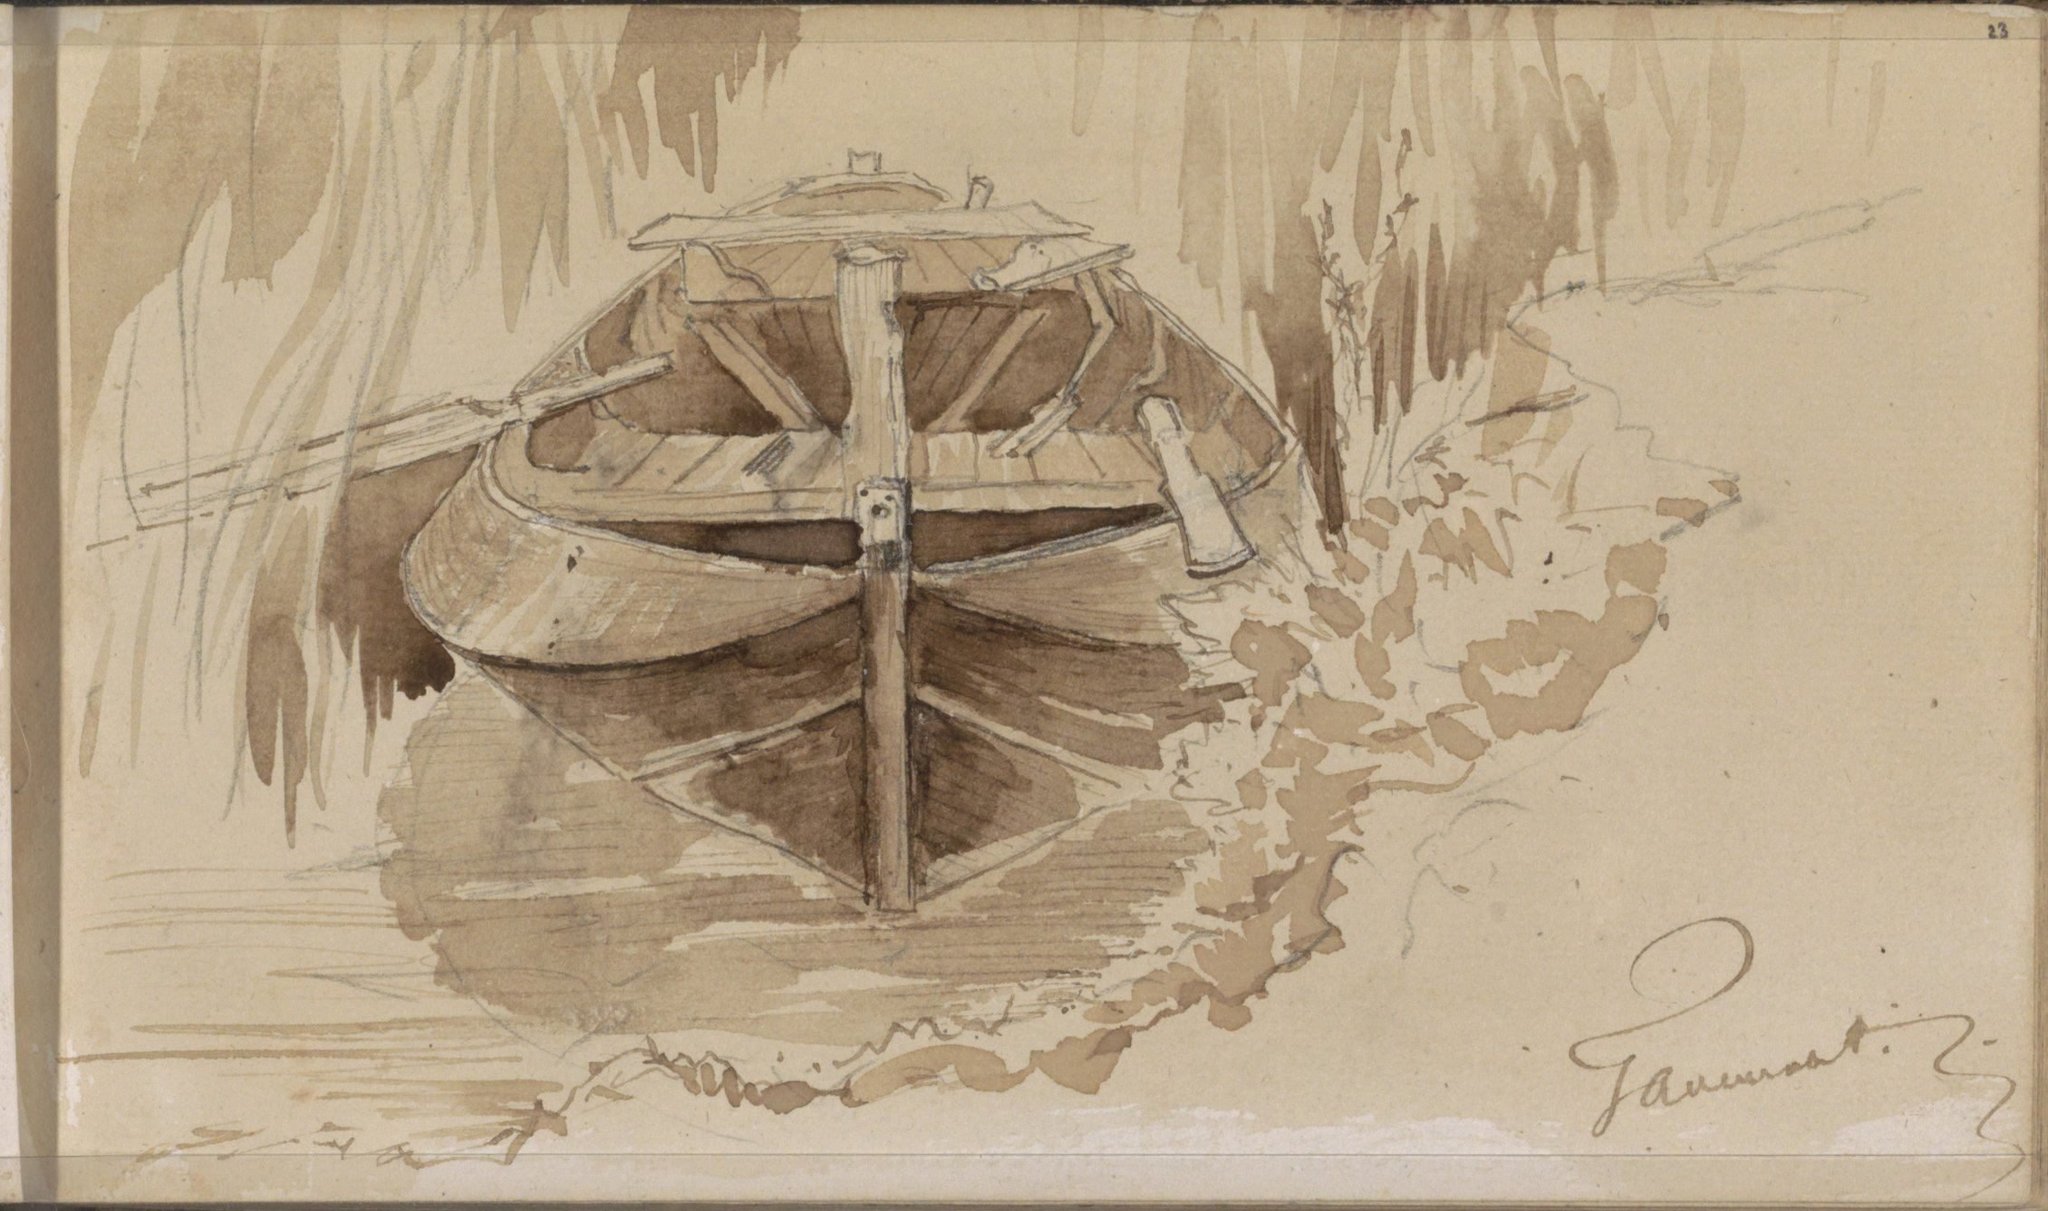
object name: sketchbook leaf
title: Roeiboot aan de waterkant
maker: johannes tavenraat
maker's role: draughtsman, painter, print maker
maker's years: 1809-1881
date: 1864-1880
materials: ink, paper, pencil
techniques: brush, pen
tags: river bank, rowing-boat, canoe, etc.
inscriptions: signature: ‘Tavenraat’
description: Blad 23 recto uit een schetsboek met 98 bladen.